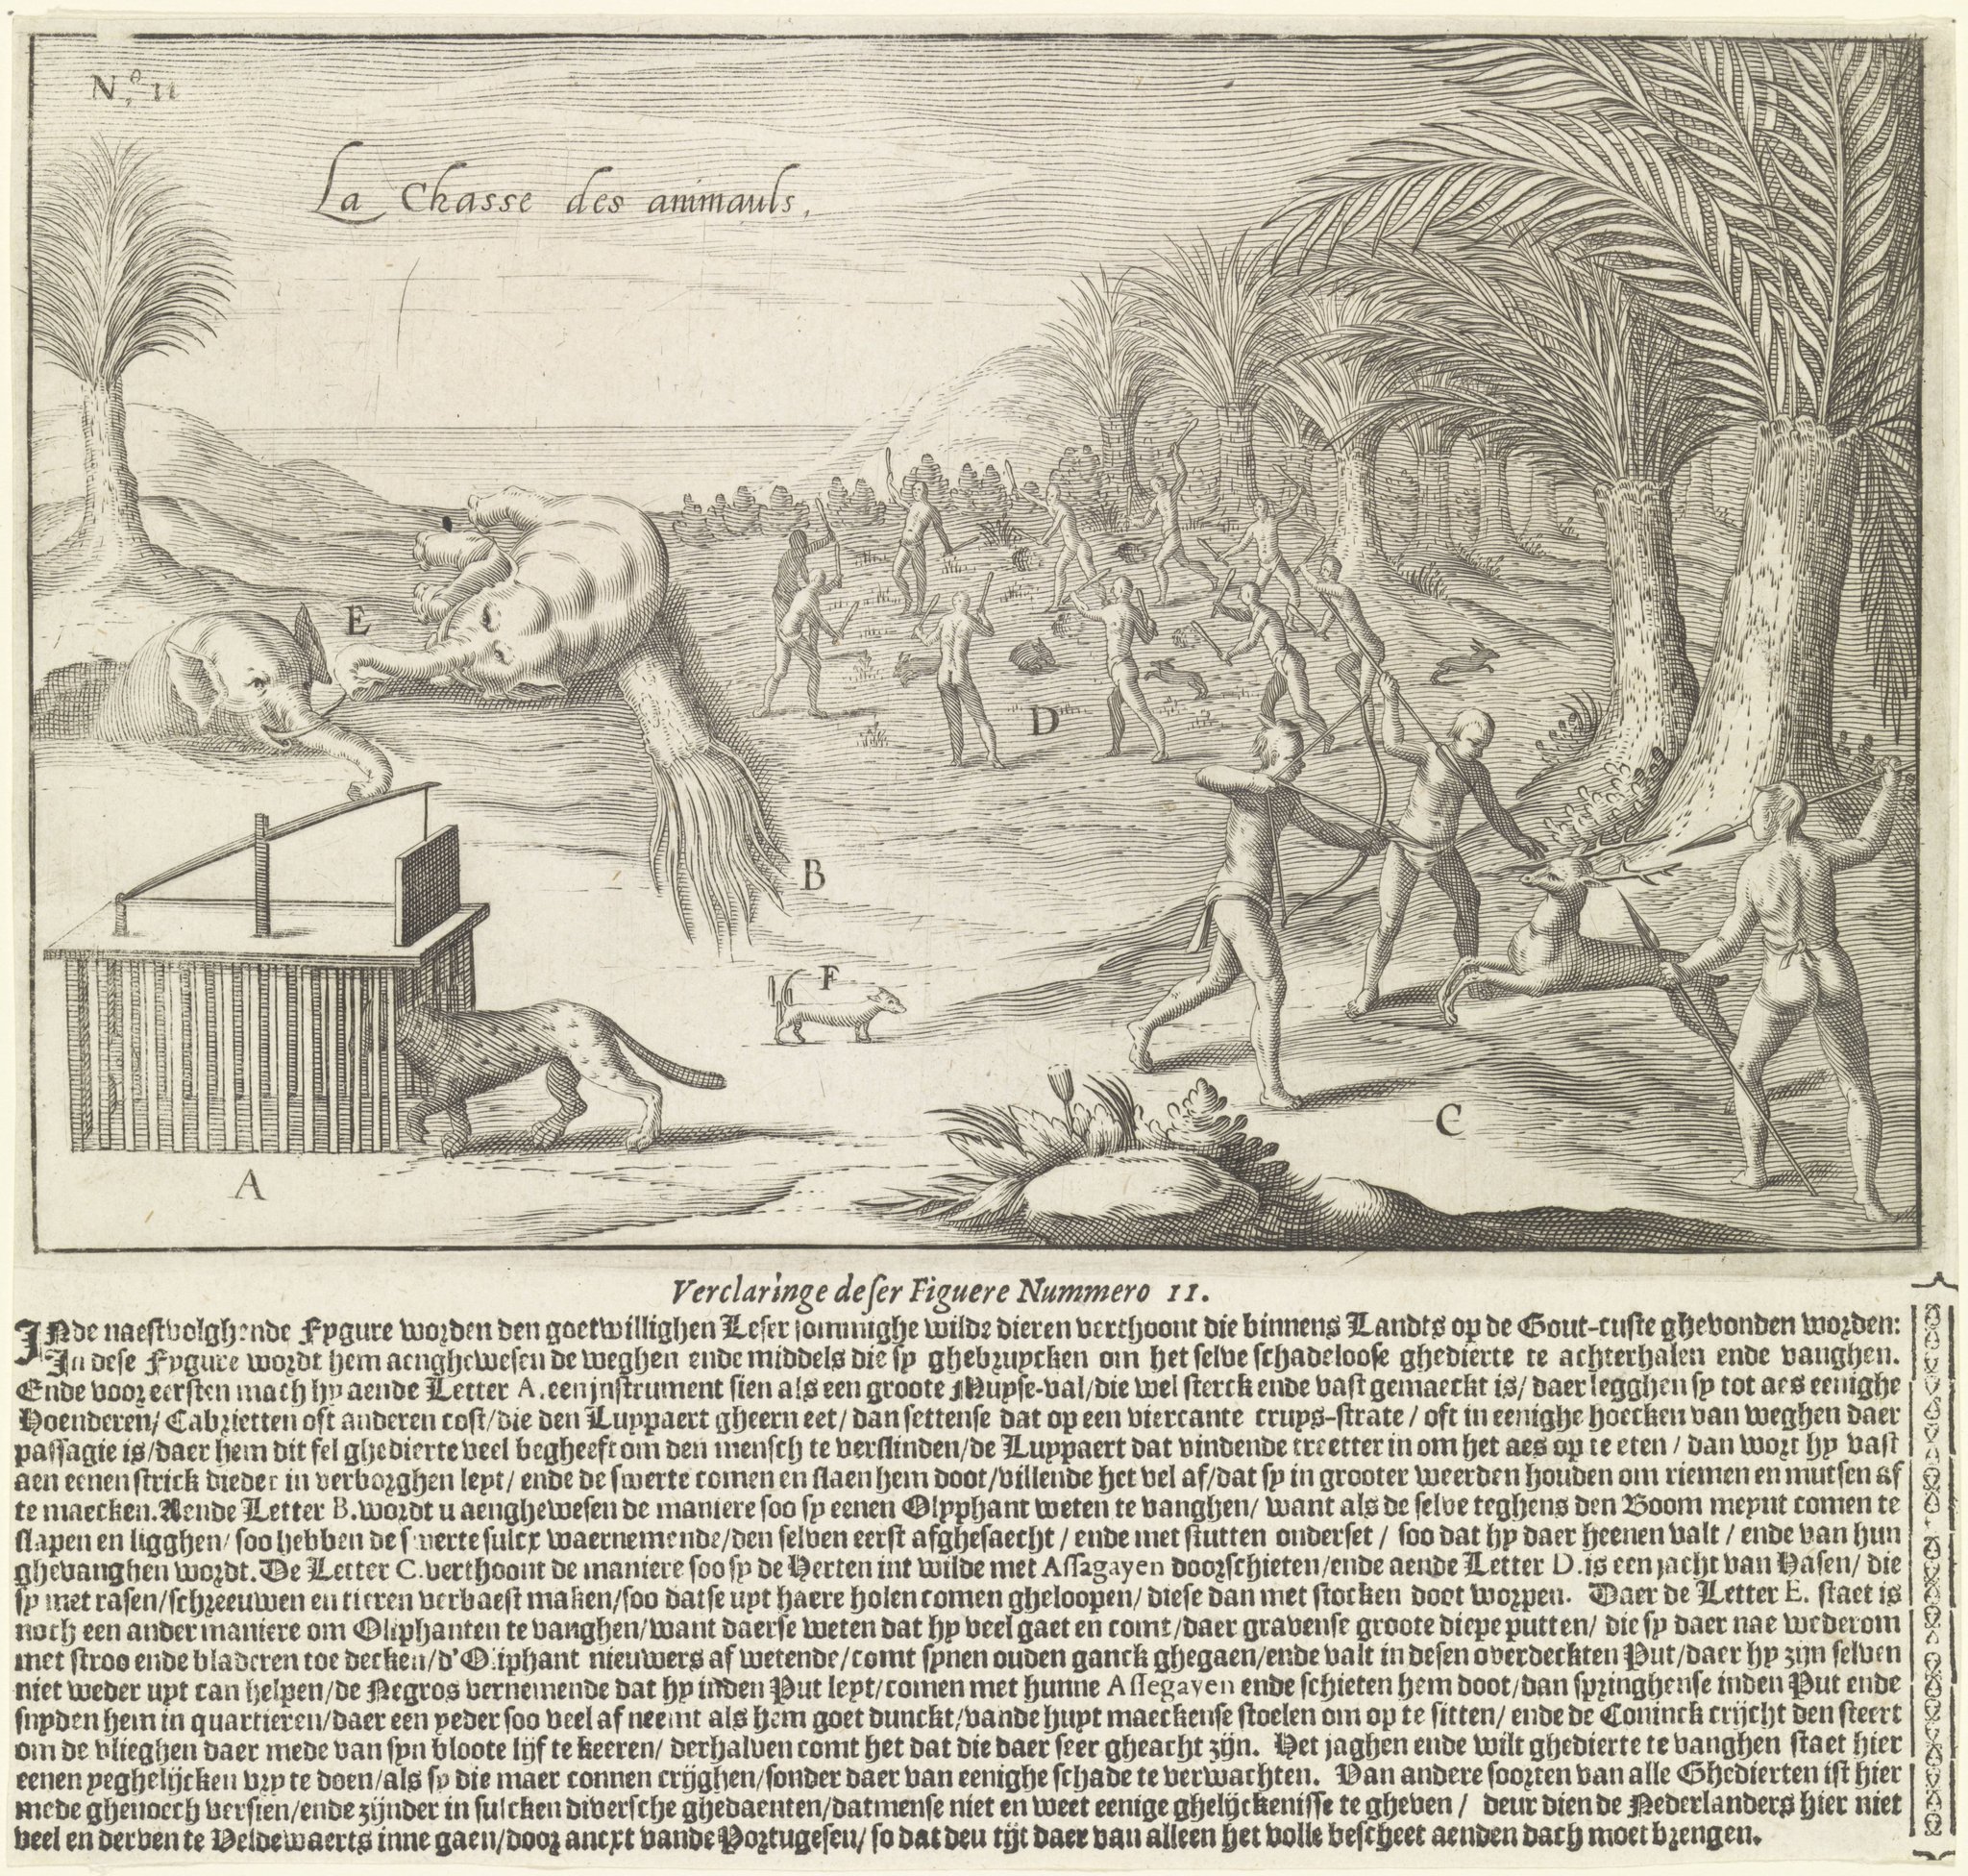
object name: print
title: Beschrijving van de goudkusten van Guinea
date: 1602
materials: paper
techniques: engraving, letterpress printing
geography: amsterdam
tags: africans (+ anthropological characteristics emphasized), hunting, chase, trunked animals: elephant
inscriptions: collector's mark: Lugt 240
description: Verschillende manieren om op inheemse dieren te jagen en ze te vangen. Links een luipaard die in een kooi gelokt wordt. Rechts herten en hazenjacht. Om olifanten te vangen zijn er twee manieren. Een verdekt gat in de grond maken waar de olifant niet zelf uit kan komen of een boom omhakken en dan weer opzetten, Als de olifant tegen de boom geleund wil slapen valt hij om en kan zich niet zelfstandig weer oprichten.